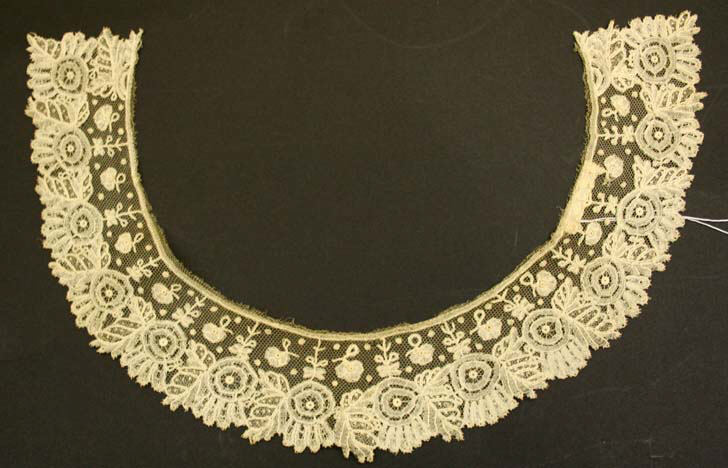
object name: collar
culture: american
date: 1886